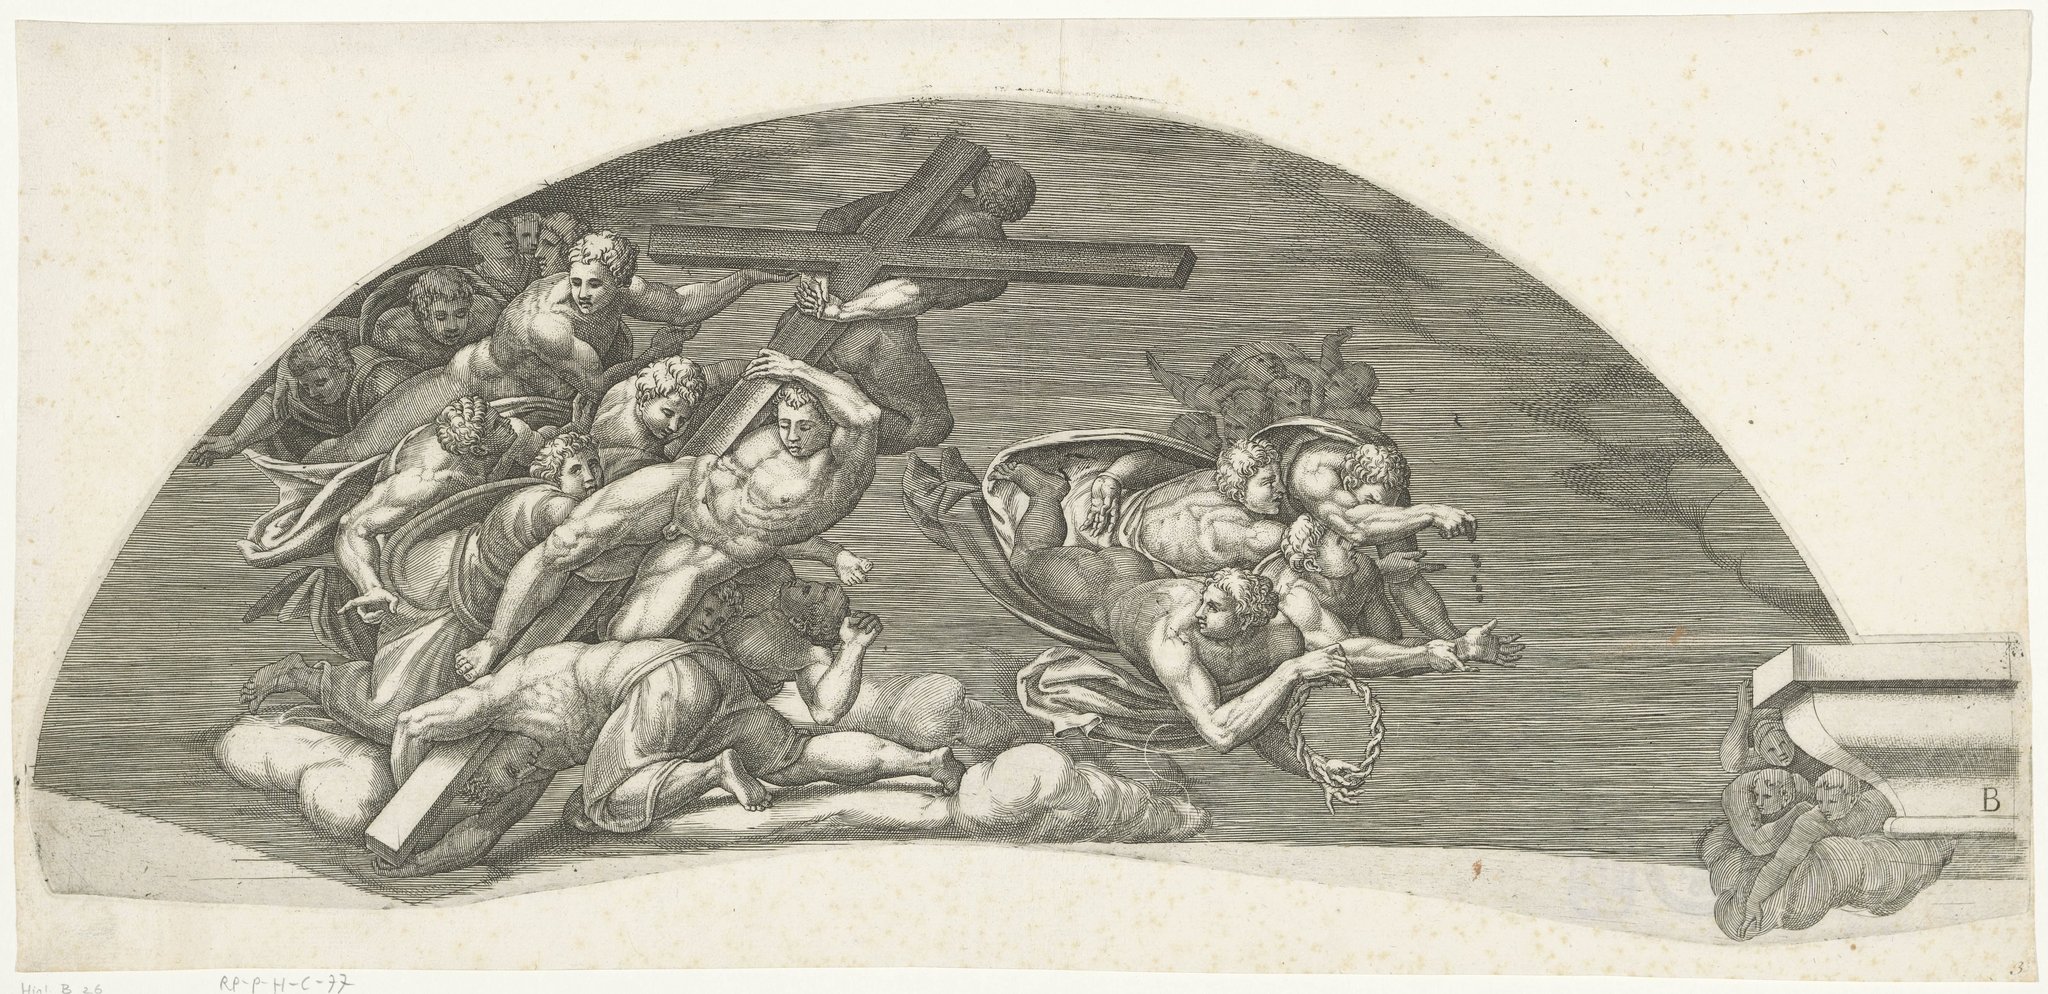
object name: print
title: Het laatste oordeel, blad B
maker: giorgio ghisi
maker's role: print maker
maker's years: 1520-1582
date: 1530-1582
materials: paper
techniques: engraving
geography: vatican city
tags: last judgement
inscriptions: number: ‘3’, collector's mark: Lugt 10, collector's mark: Lugt 11, collector's mark: ‘Hinloopen’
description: Prent maakt deel uit van een groep van tien prenten die samen één grote voorstelling vormen naar het fresco met het Laatste Oordeel door Michelangelo in de Sixtijnse Kapel in het Vaticaan.